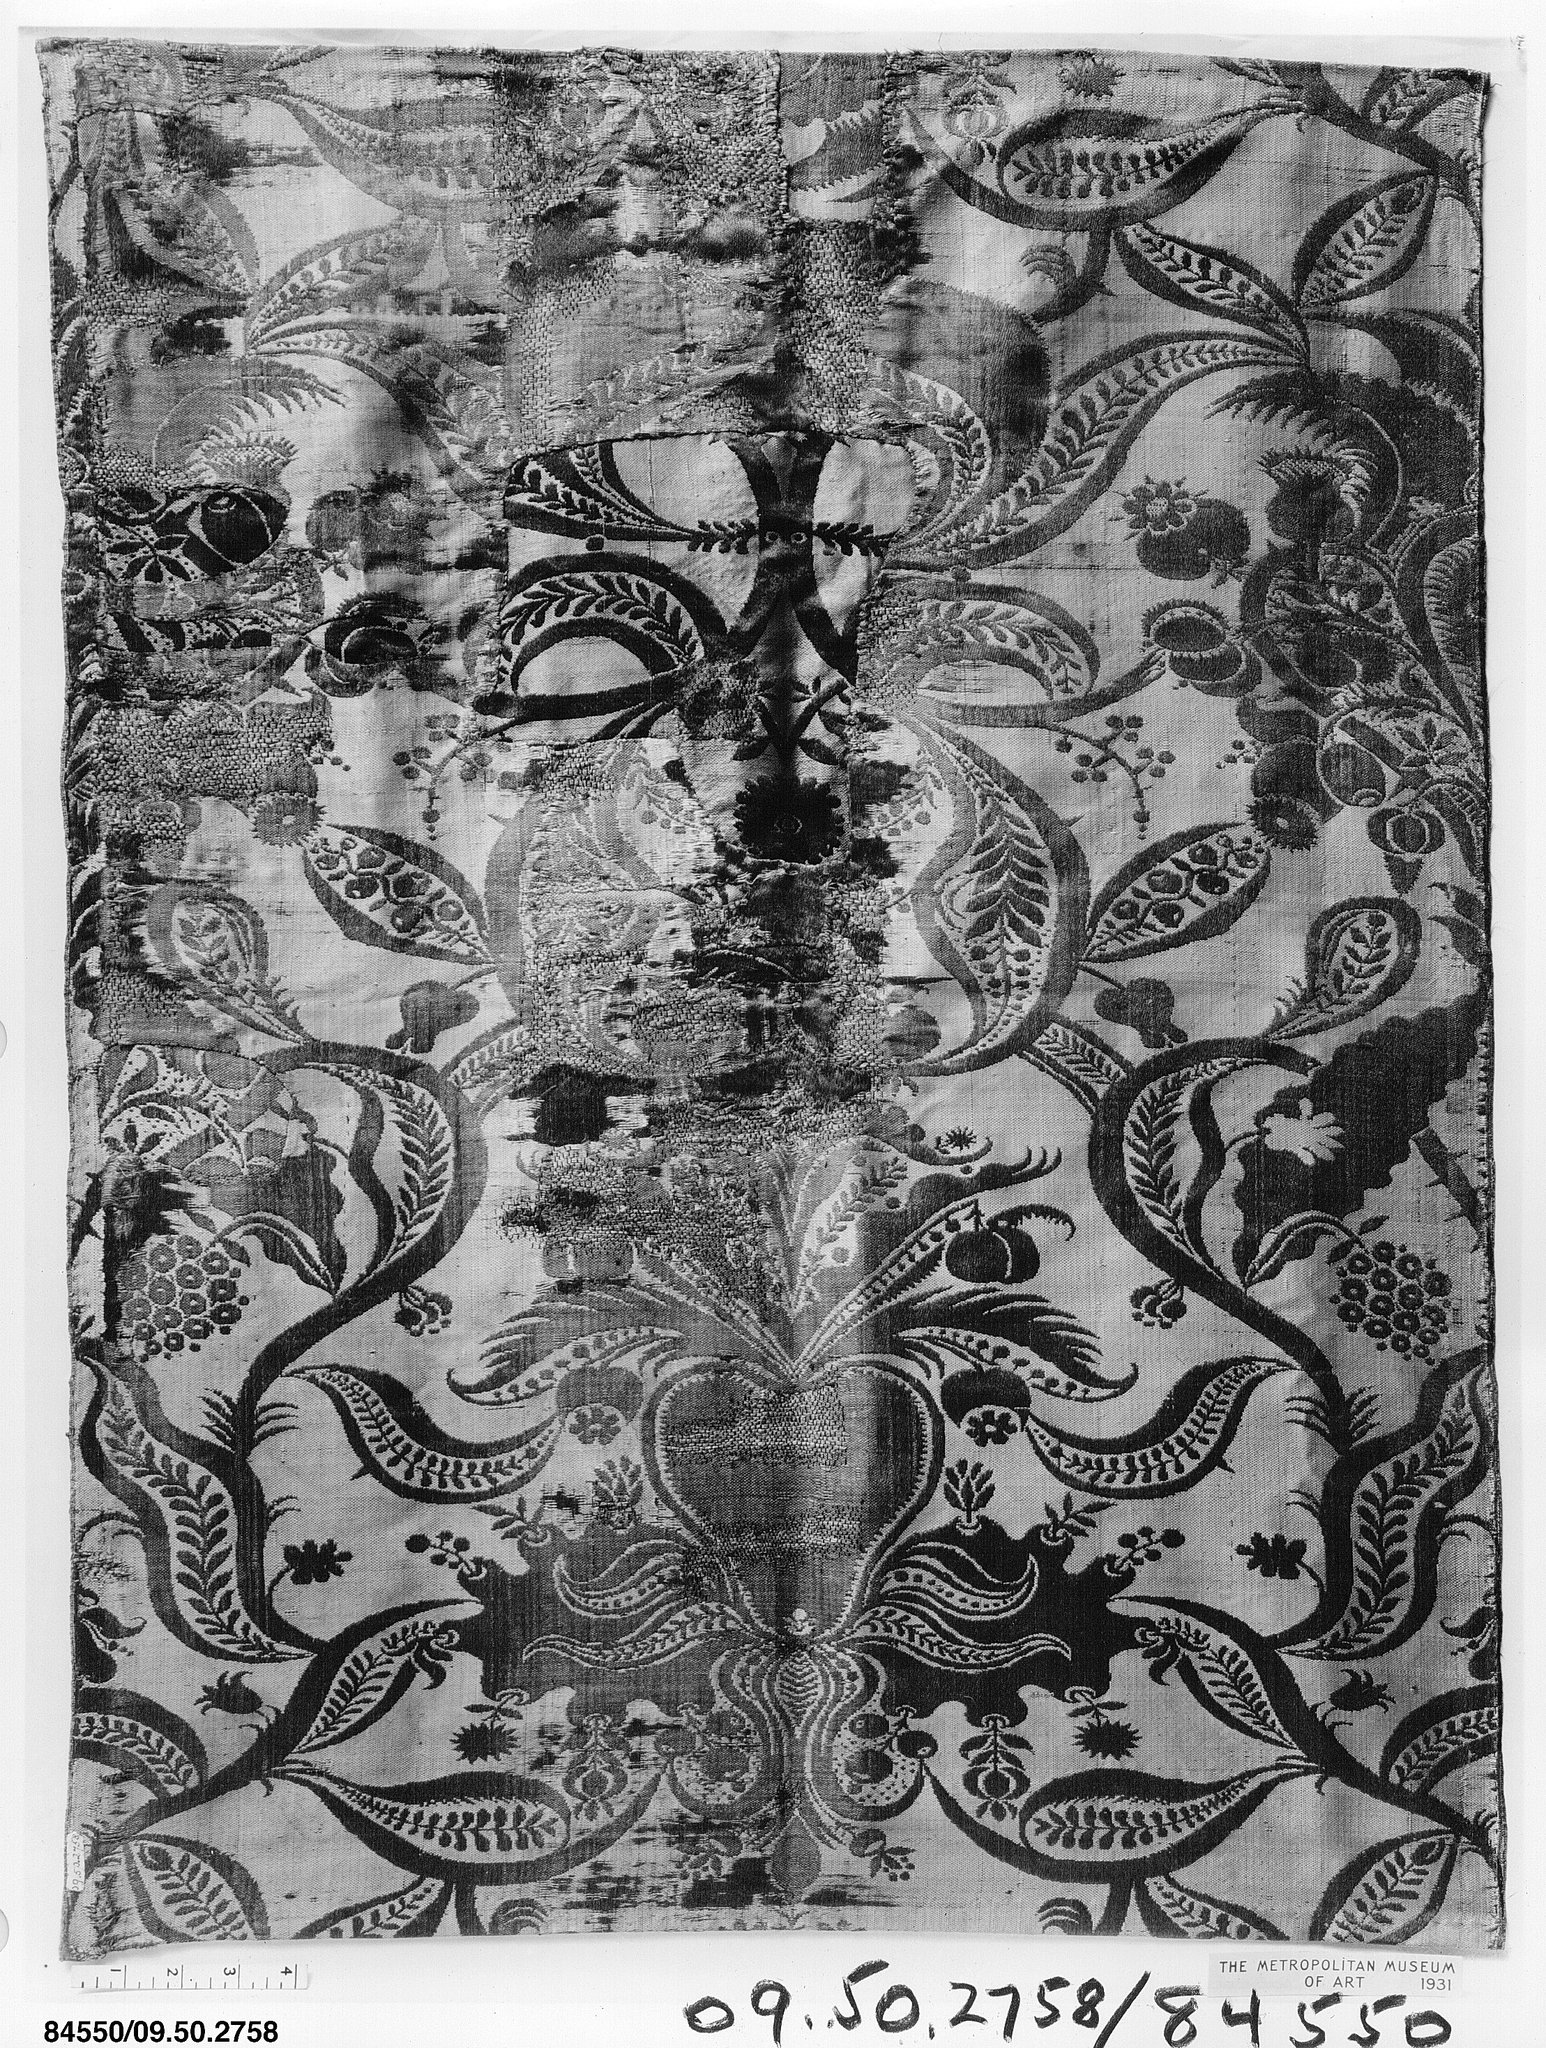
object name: piece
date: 1501-1700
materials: silk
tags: leaves